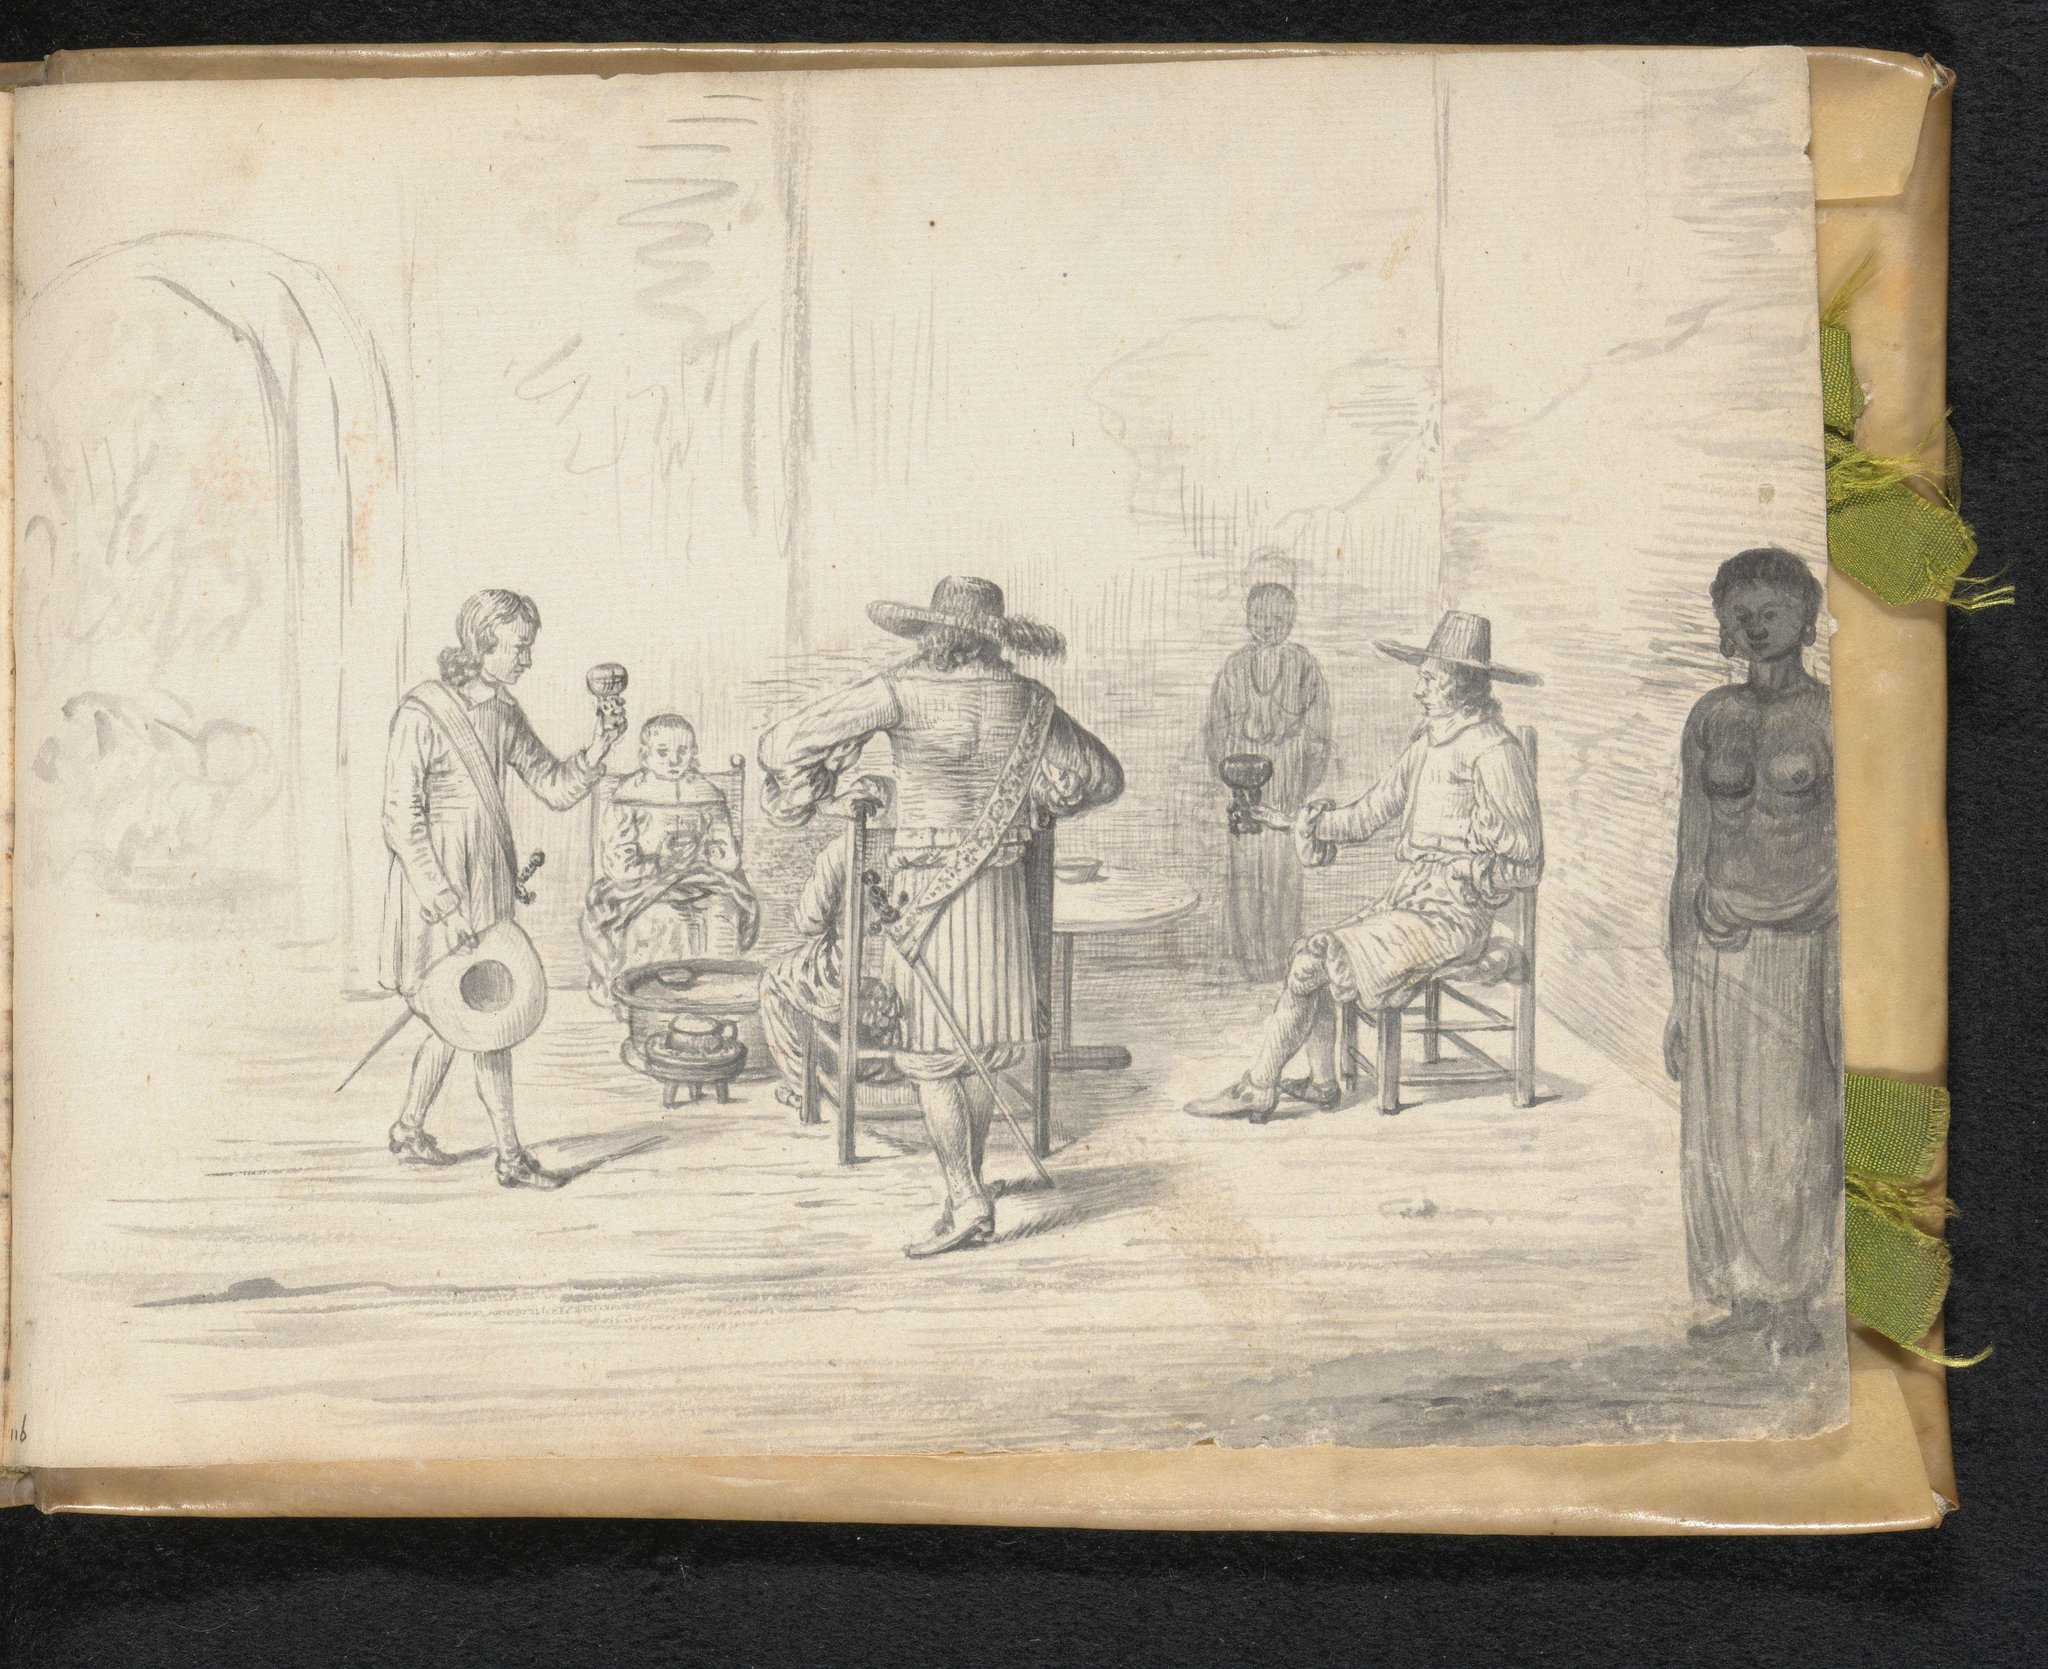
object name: sketchbook leaf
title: Scene with a party in a tavern or living room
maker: esaias boursse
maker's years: 1631-1672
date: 1662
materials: ink, paper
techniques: brush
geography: sri lanka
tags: asiatic races and peoples (with name), 41d232(...) skirt (lungi), eurasion, half-caste, asian races and peoples (with name), skirt (with name), clothing for the upper part of the body (with name), stretching parts of the body (lips, earlobes, etc.), inn, coffee-house, public house, etc., interior of the house, glass of wine, ears, europeans (with name), sri lanka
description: Interieur van een logement op Ceylon of aan de Kaap de Goede Hoop met dienaren van de Verenigde Oostindische Compagnie en hun vrouwen en bedienden.